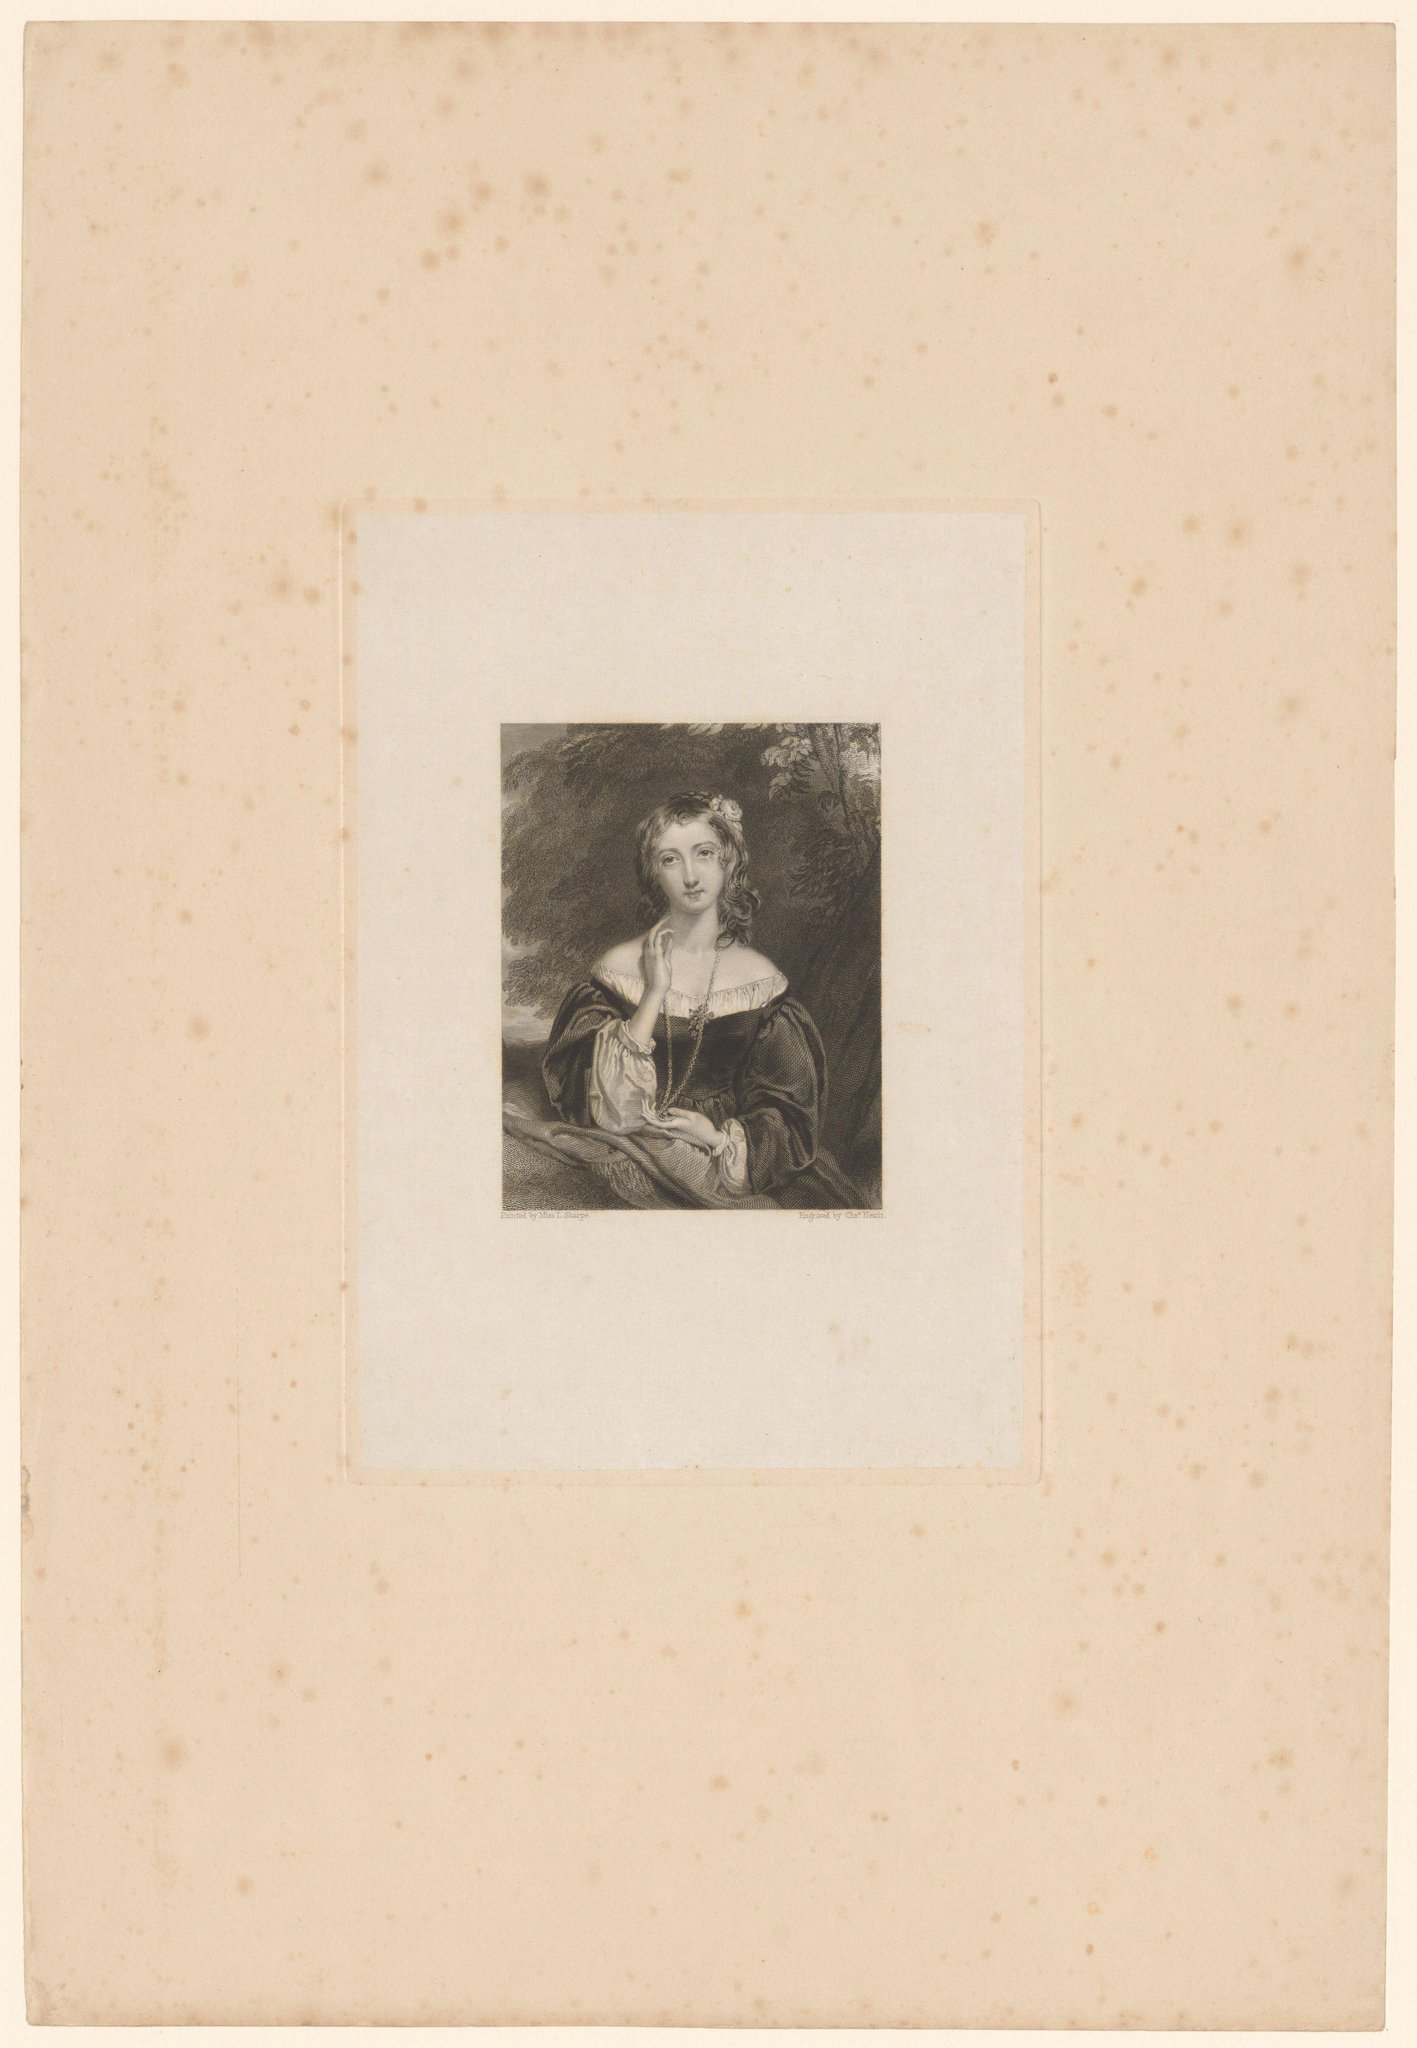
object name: book illustration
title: Jonge vrouw met medaillon om haar nek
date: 1831-1832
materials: paper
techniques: etching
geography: great britain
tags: female literary characters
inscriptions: collector's mark: Lugt 2228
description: Prent uit: The Keepsake for 1832, 1831-1832.